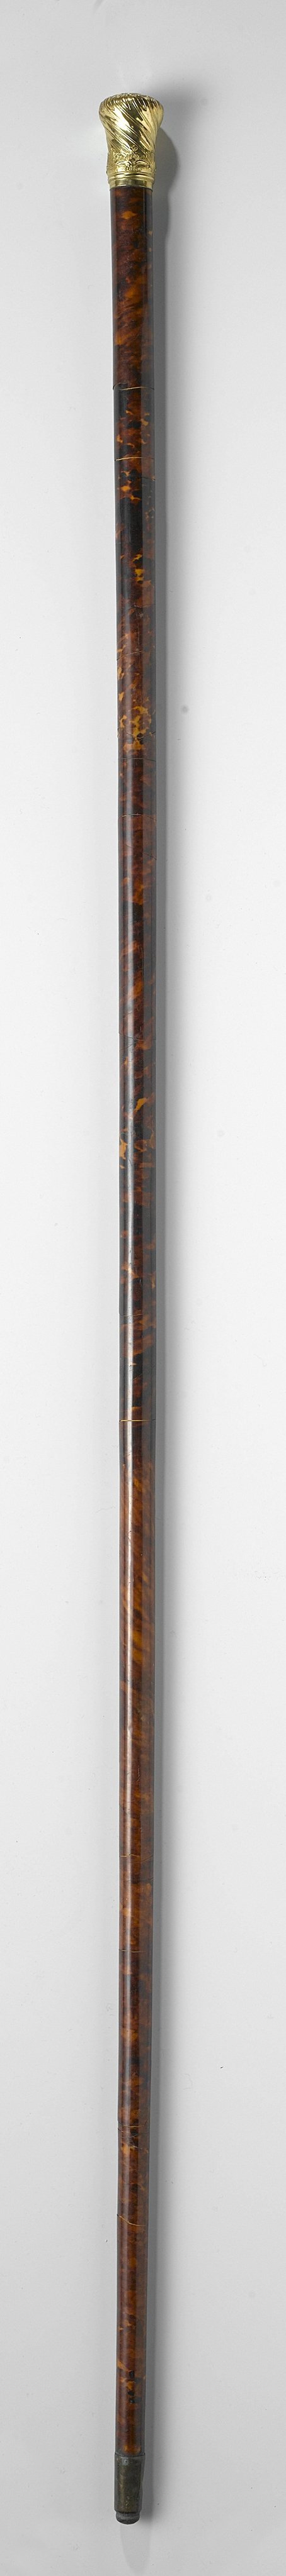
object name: walking stick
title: Wandelstok van schildpad met gedreven, vergulde koperen knop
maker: Anonymous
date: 1700-1715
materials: copper, shell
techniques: cutting, forging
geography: europe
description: Wandelstok van schildpad met vergulde koperen gedreven knop.